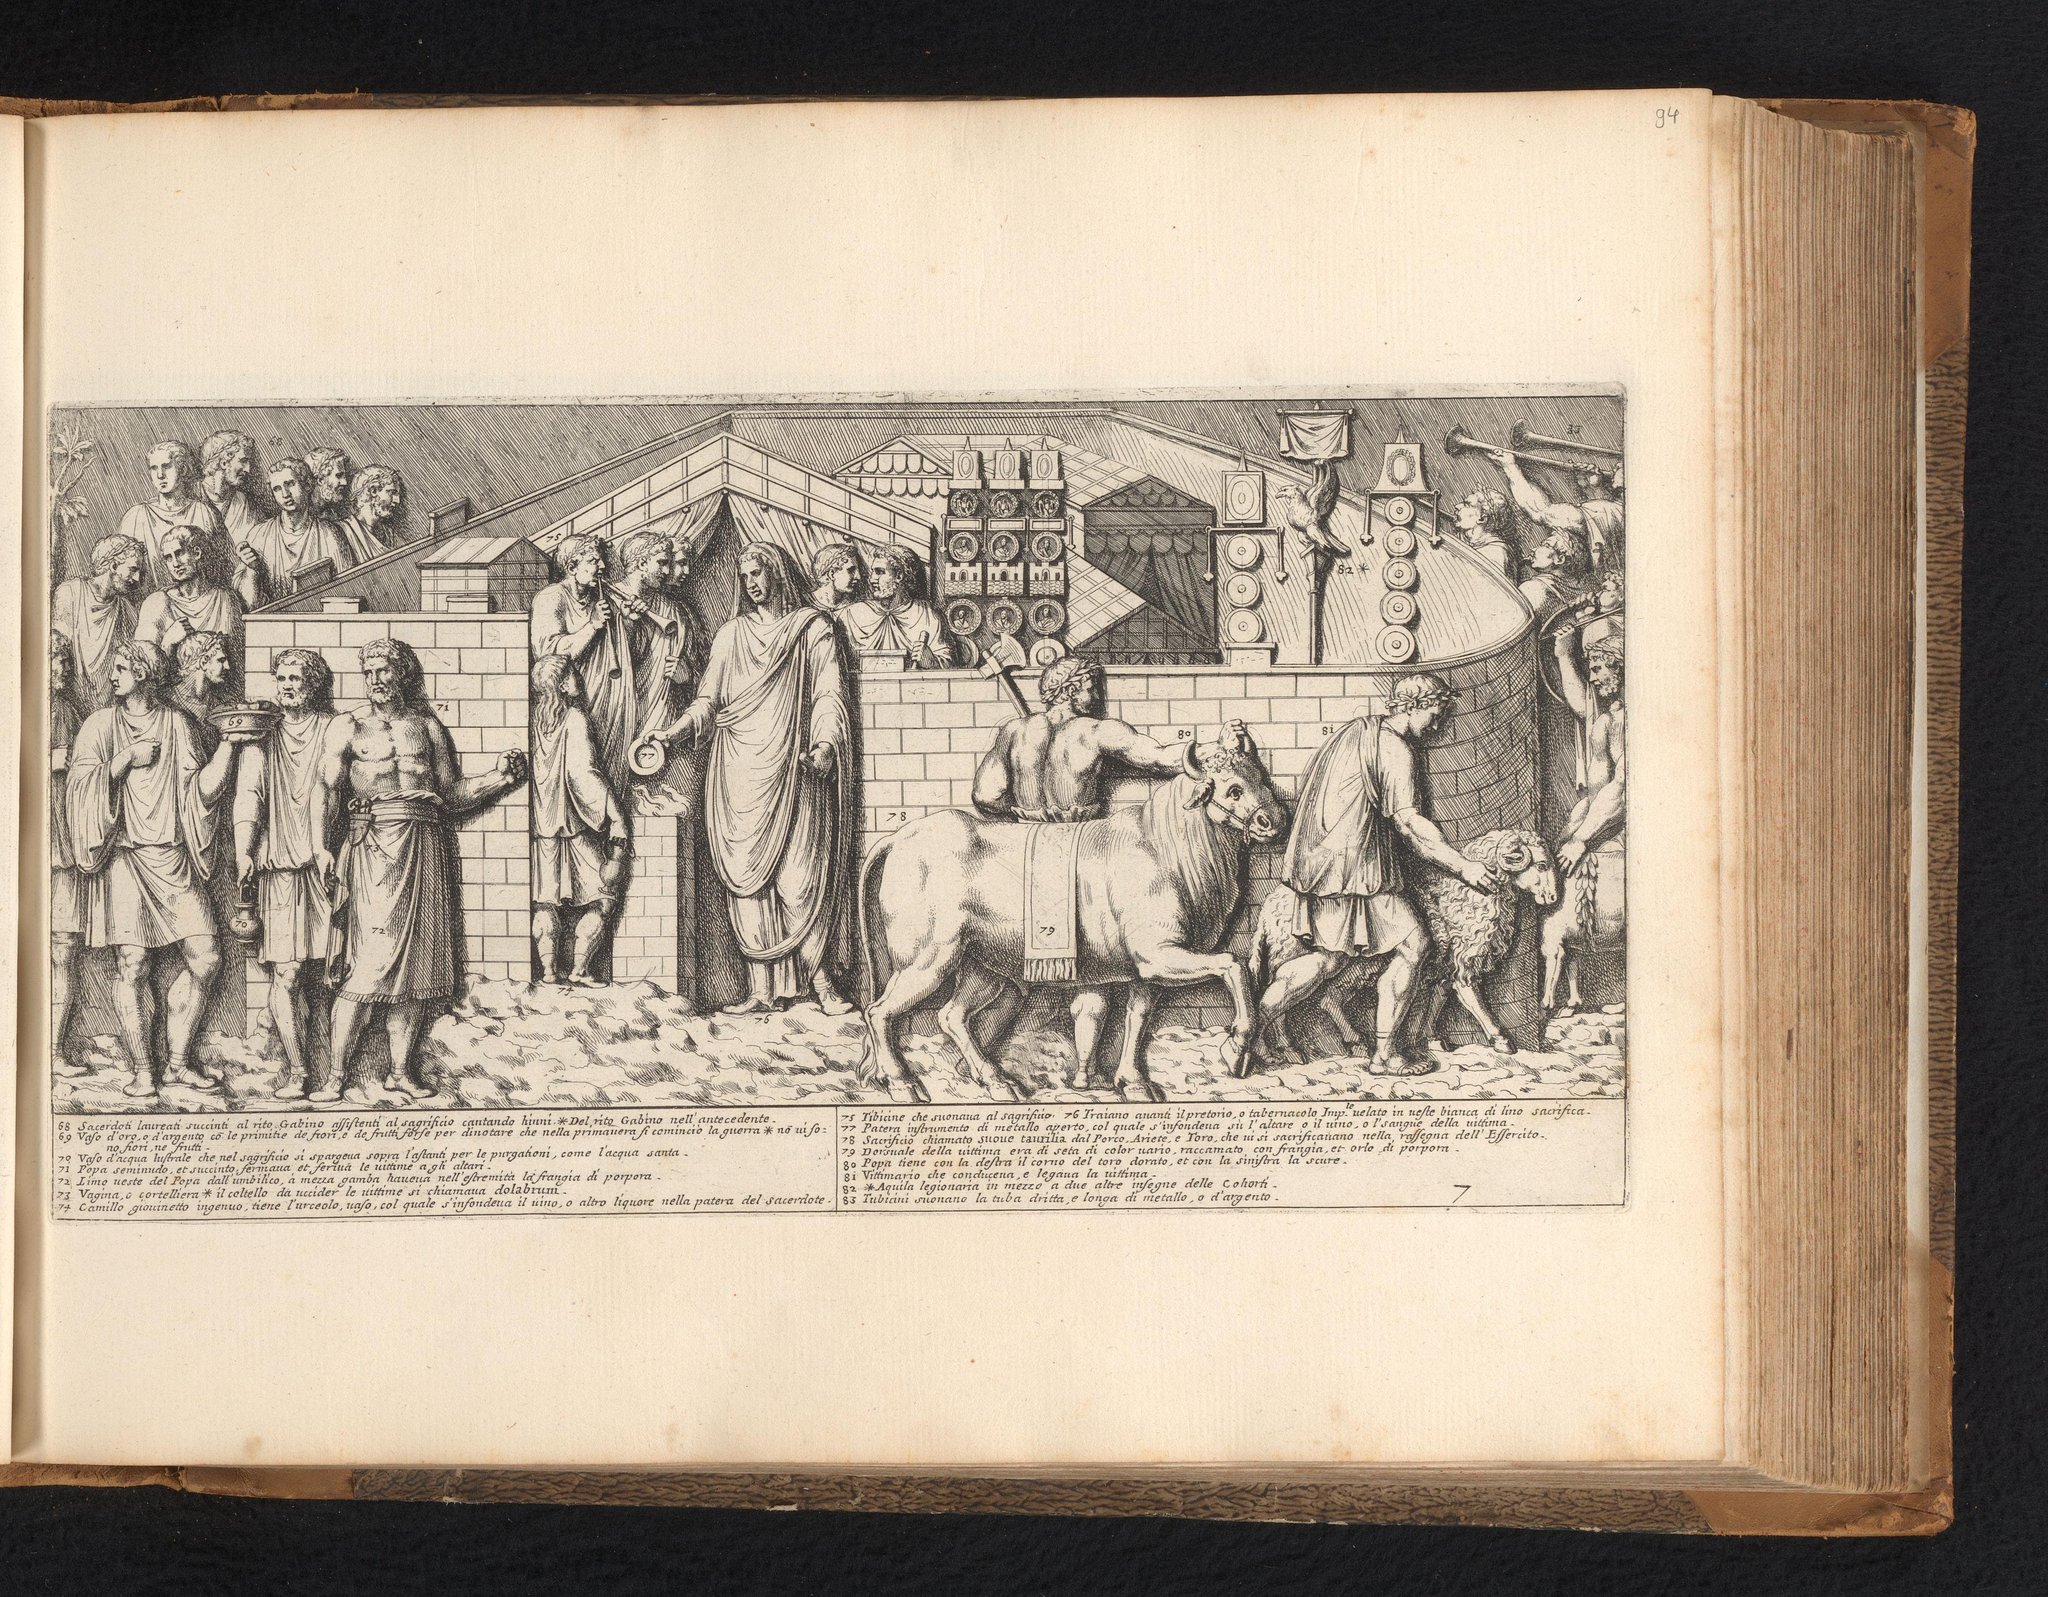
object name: print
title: Colonna Traiana eretta dal senato, e popolo Romano all' imperatore Traiano Augusto nel suo foro in Rom (...)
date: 1637-1691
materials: paper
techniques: etching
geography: rome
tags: triumphal column with helical friezes, piece of sculpture, reproduction of a piece of sculpture, the soldier; the soldier's life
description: Detail van het spiraalvormige gebeeldhouwde fries op de Zuil van Trajanus. Het fries toont de oorlogen tussen de Romeinen en de Daciërs. Verklarende nummers in de ondermarge. Prent maakt deel uit van een album.